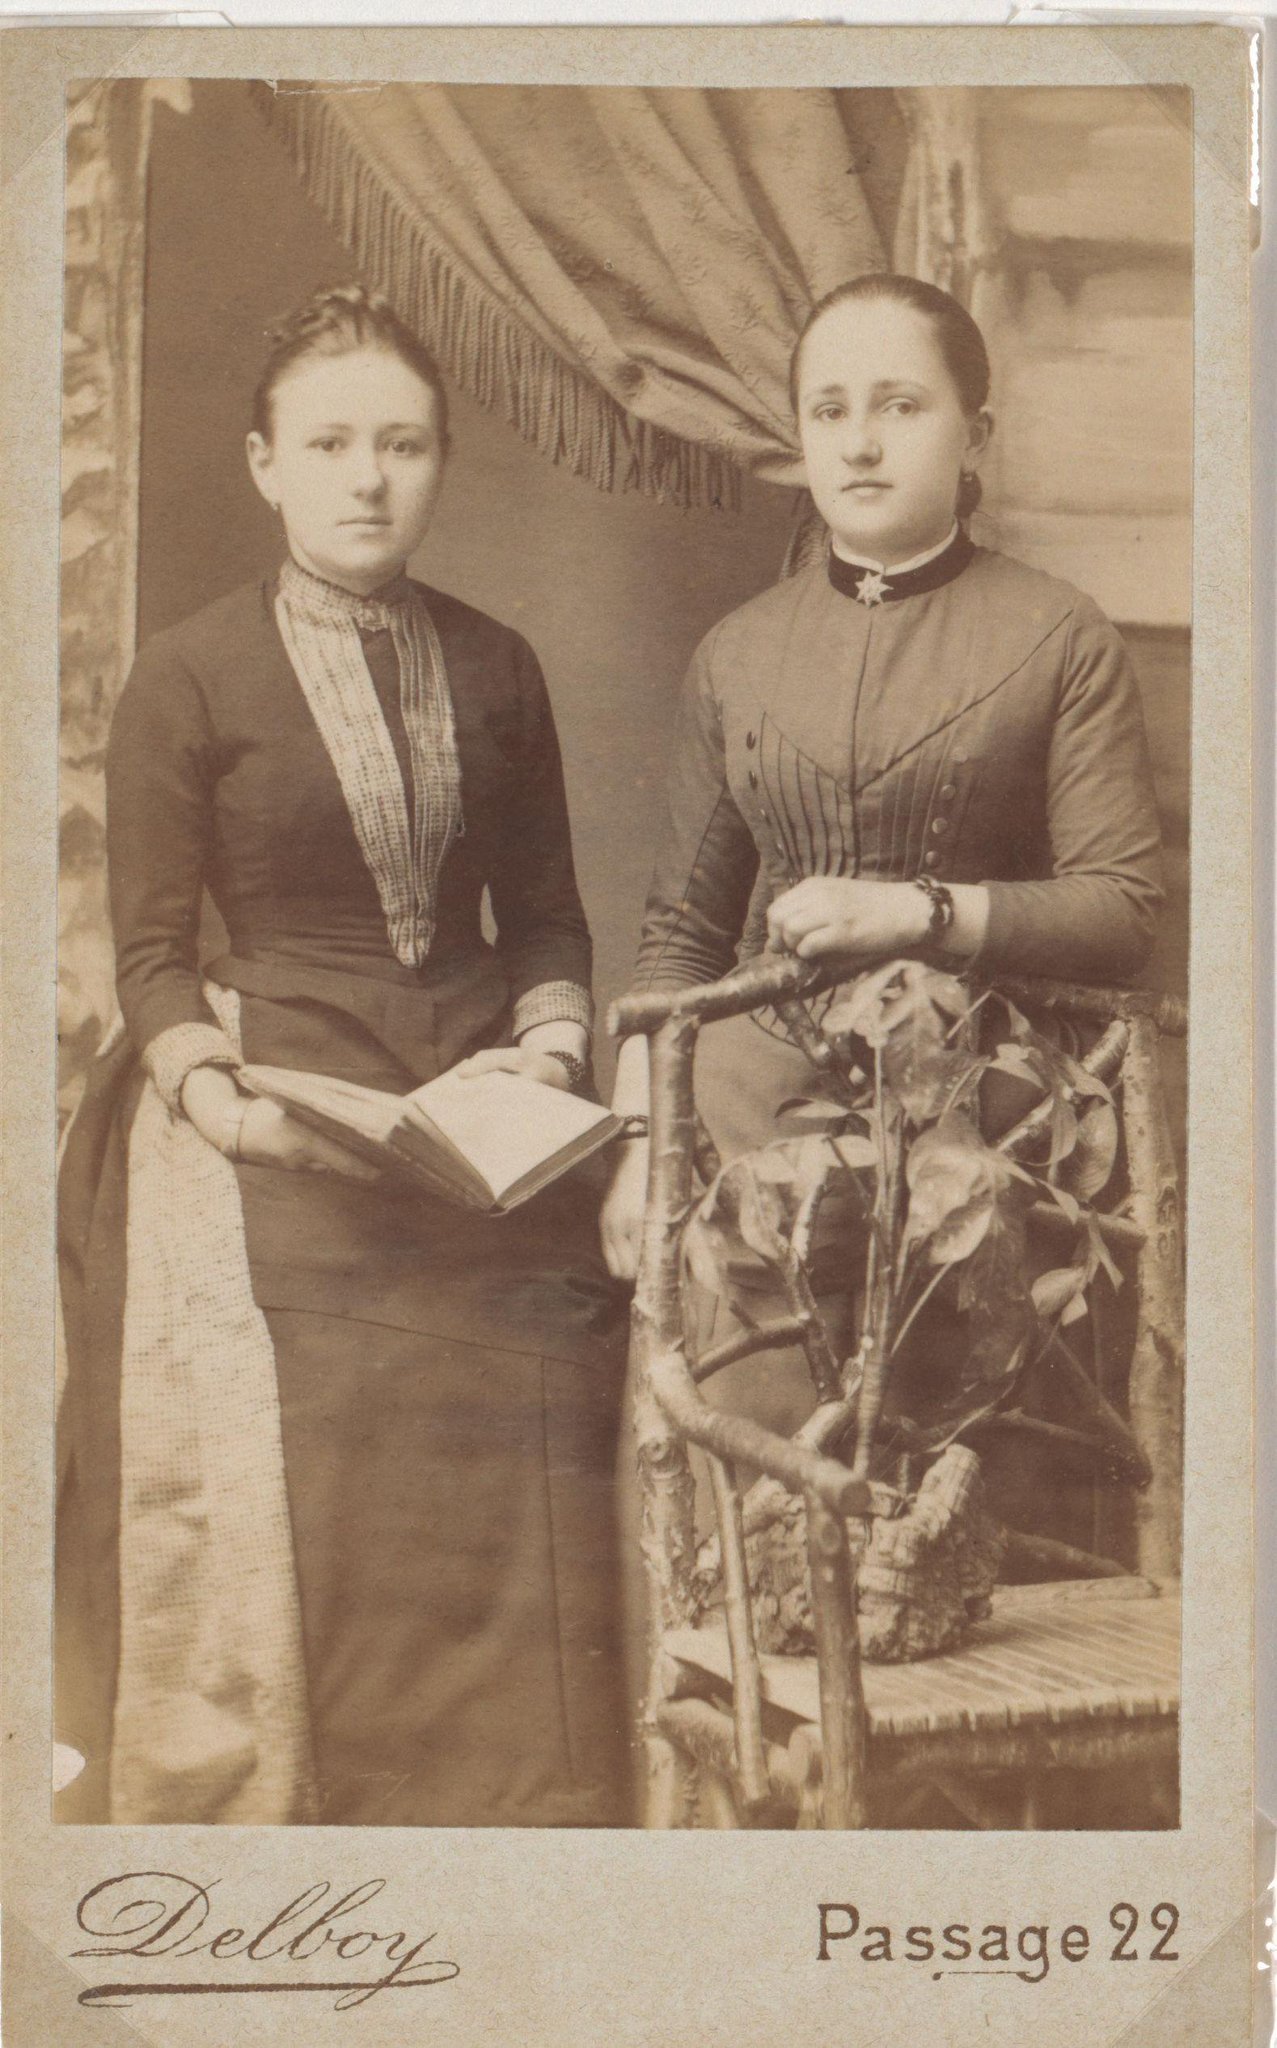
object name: carte de visite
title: Portret van twee vrouwen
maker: wilhelm frederick antonius delboy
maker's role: fotograaf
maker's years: 1853-1928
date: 1887-1900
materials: cardboard, paper, photographic support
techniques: albumen print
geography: the hague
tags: studio requisites ~ photographer, historical persons, the hague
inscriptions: address: ‘Passage 22 Den Haag’